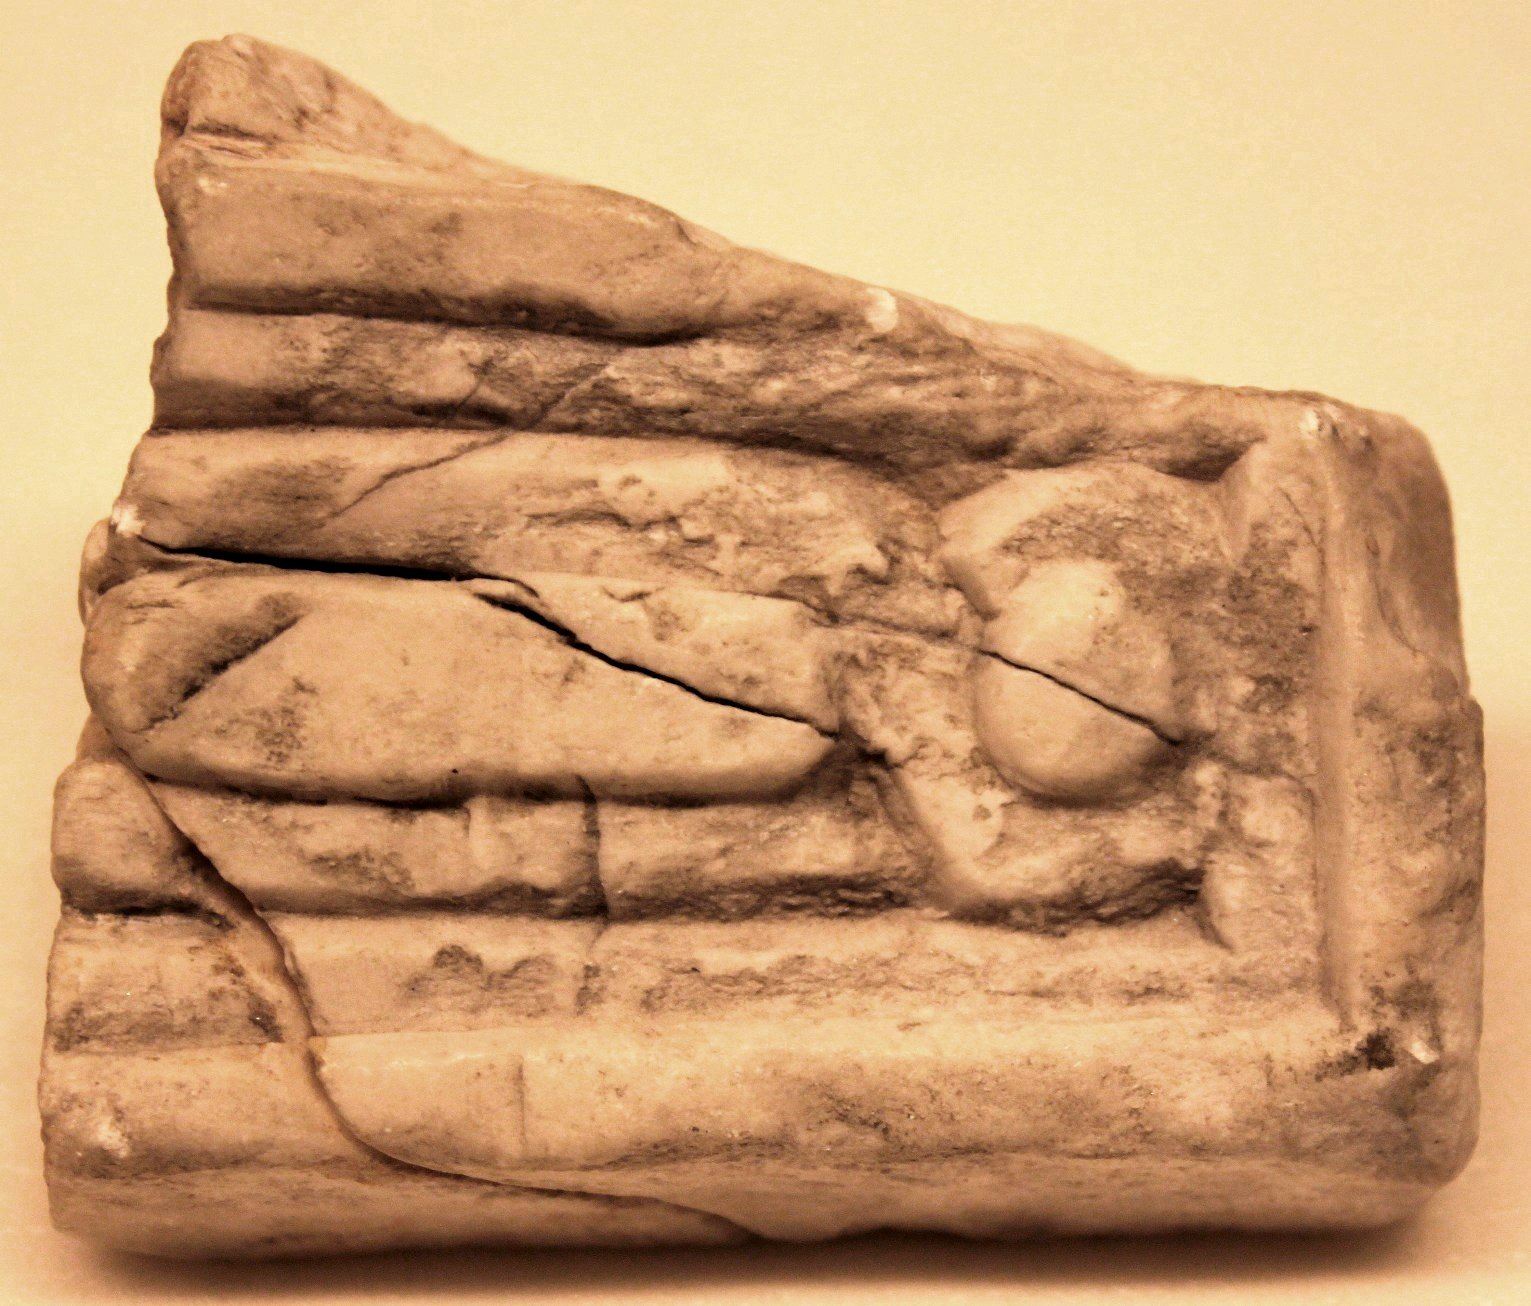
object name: stone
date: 701-1200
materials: stone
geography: iran